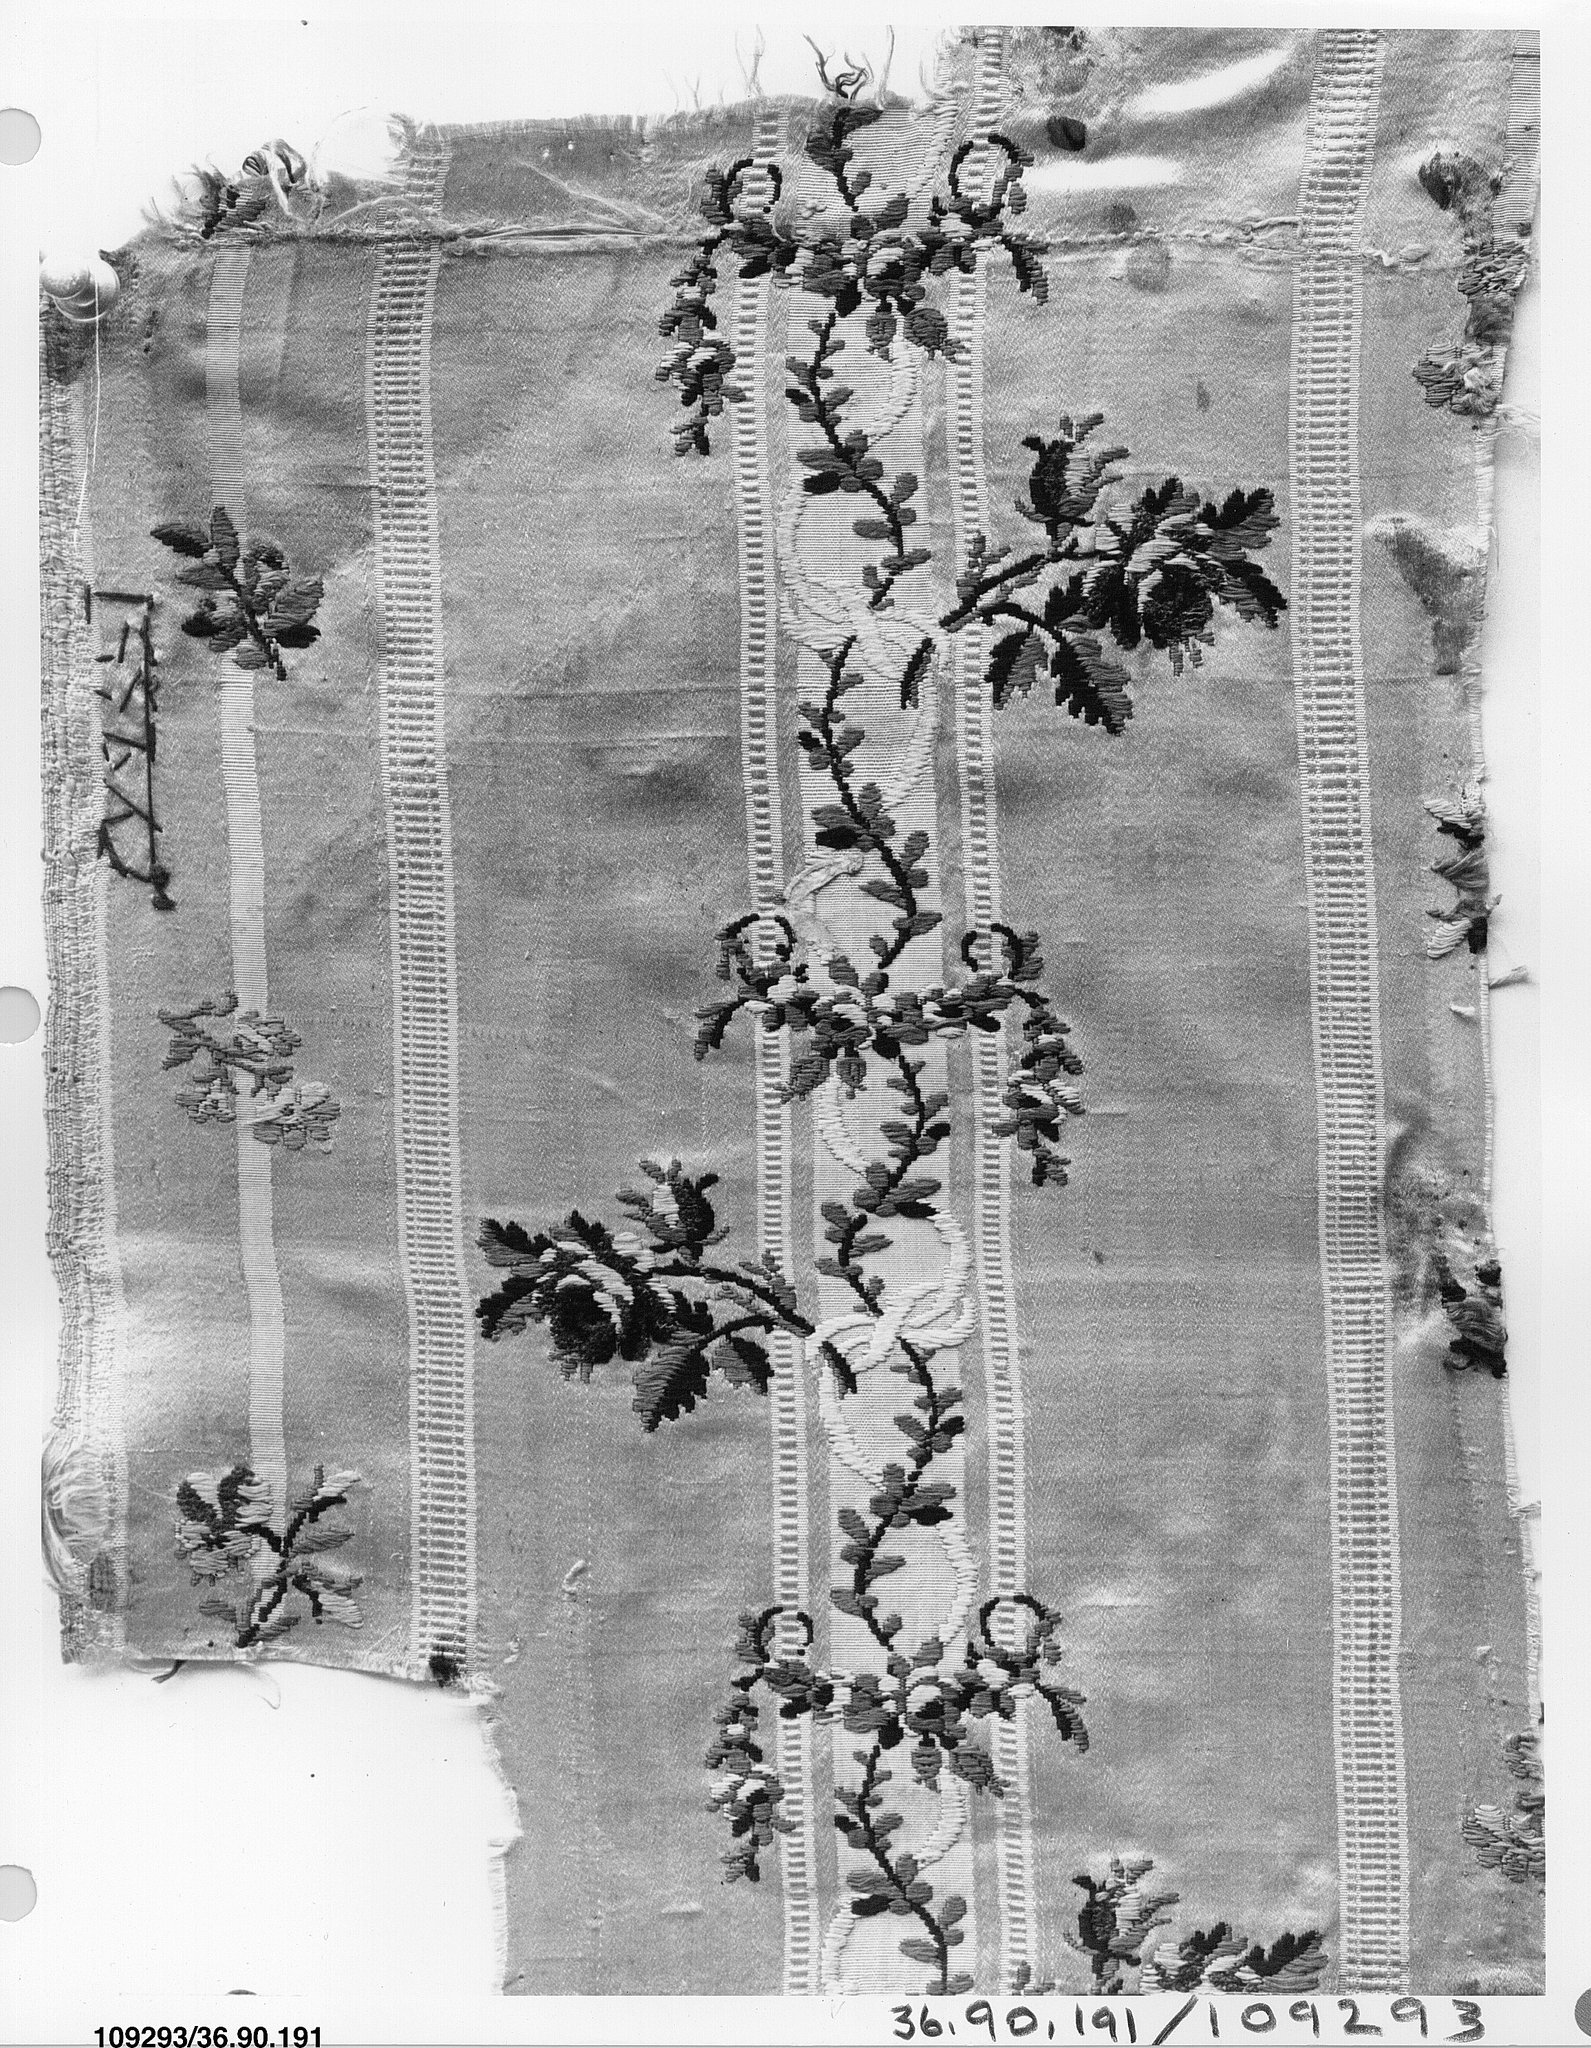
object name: piece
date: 1701-1800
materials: silk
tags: flowers,leaves